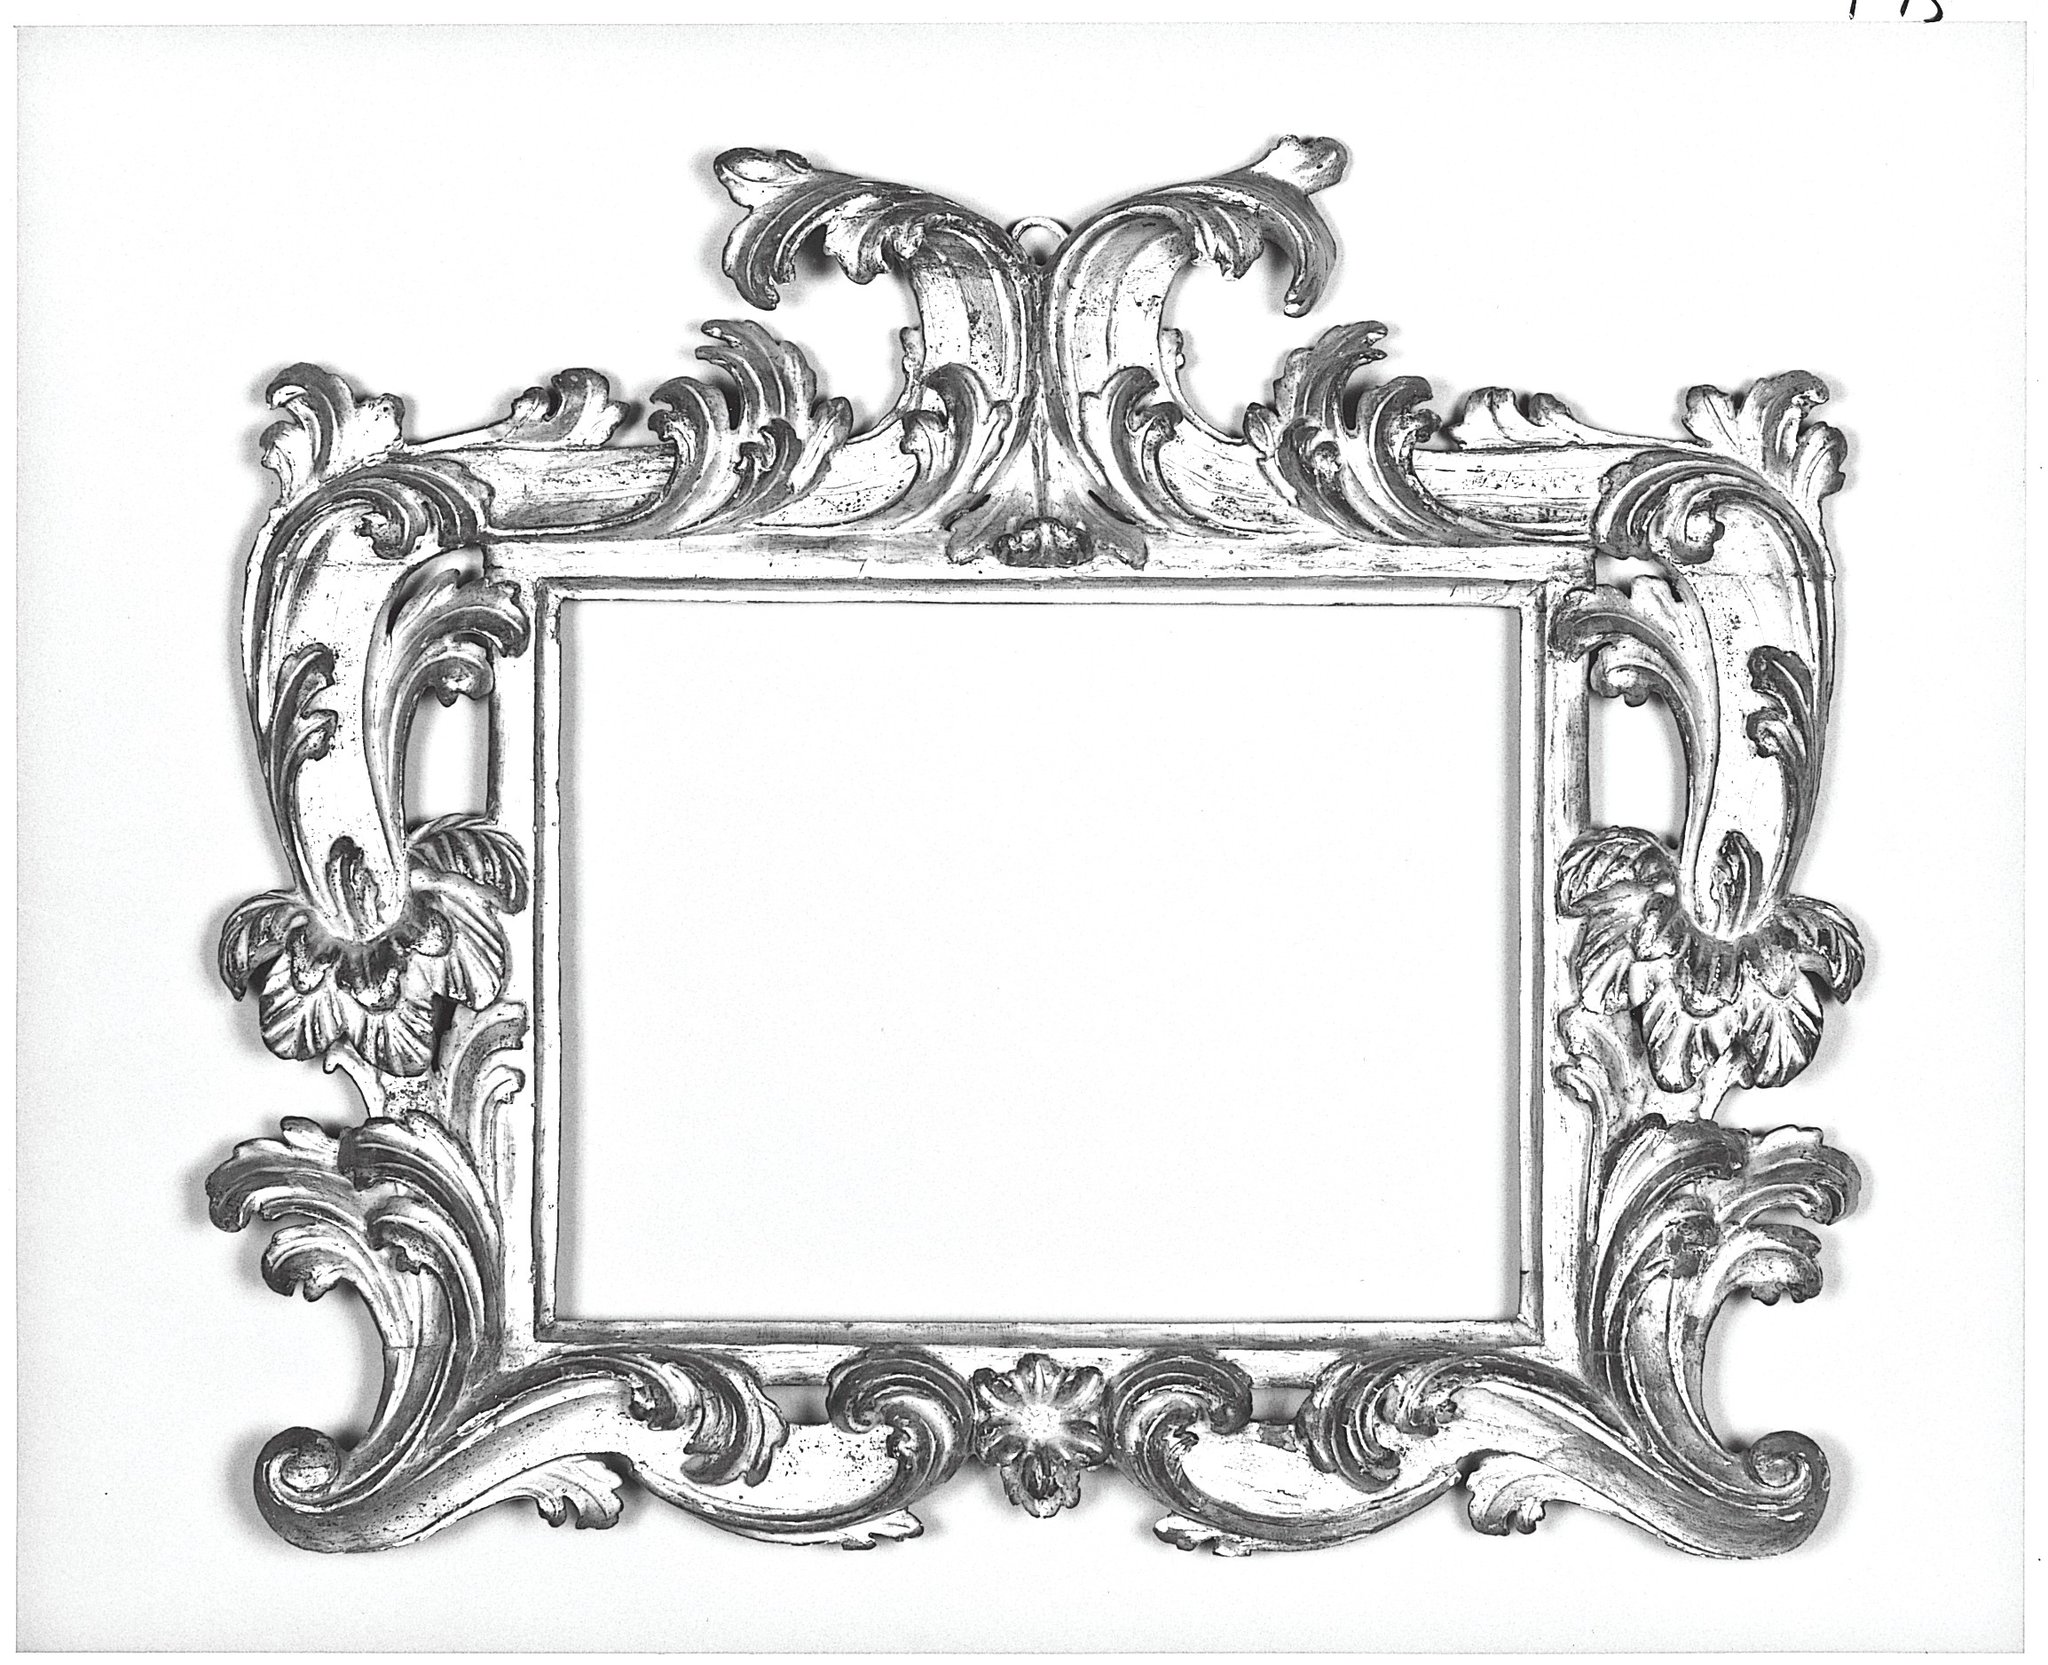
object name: frame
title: Cauliculi frame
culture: italian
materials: wood